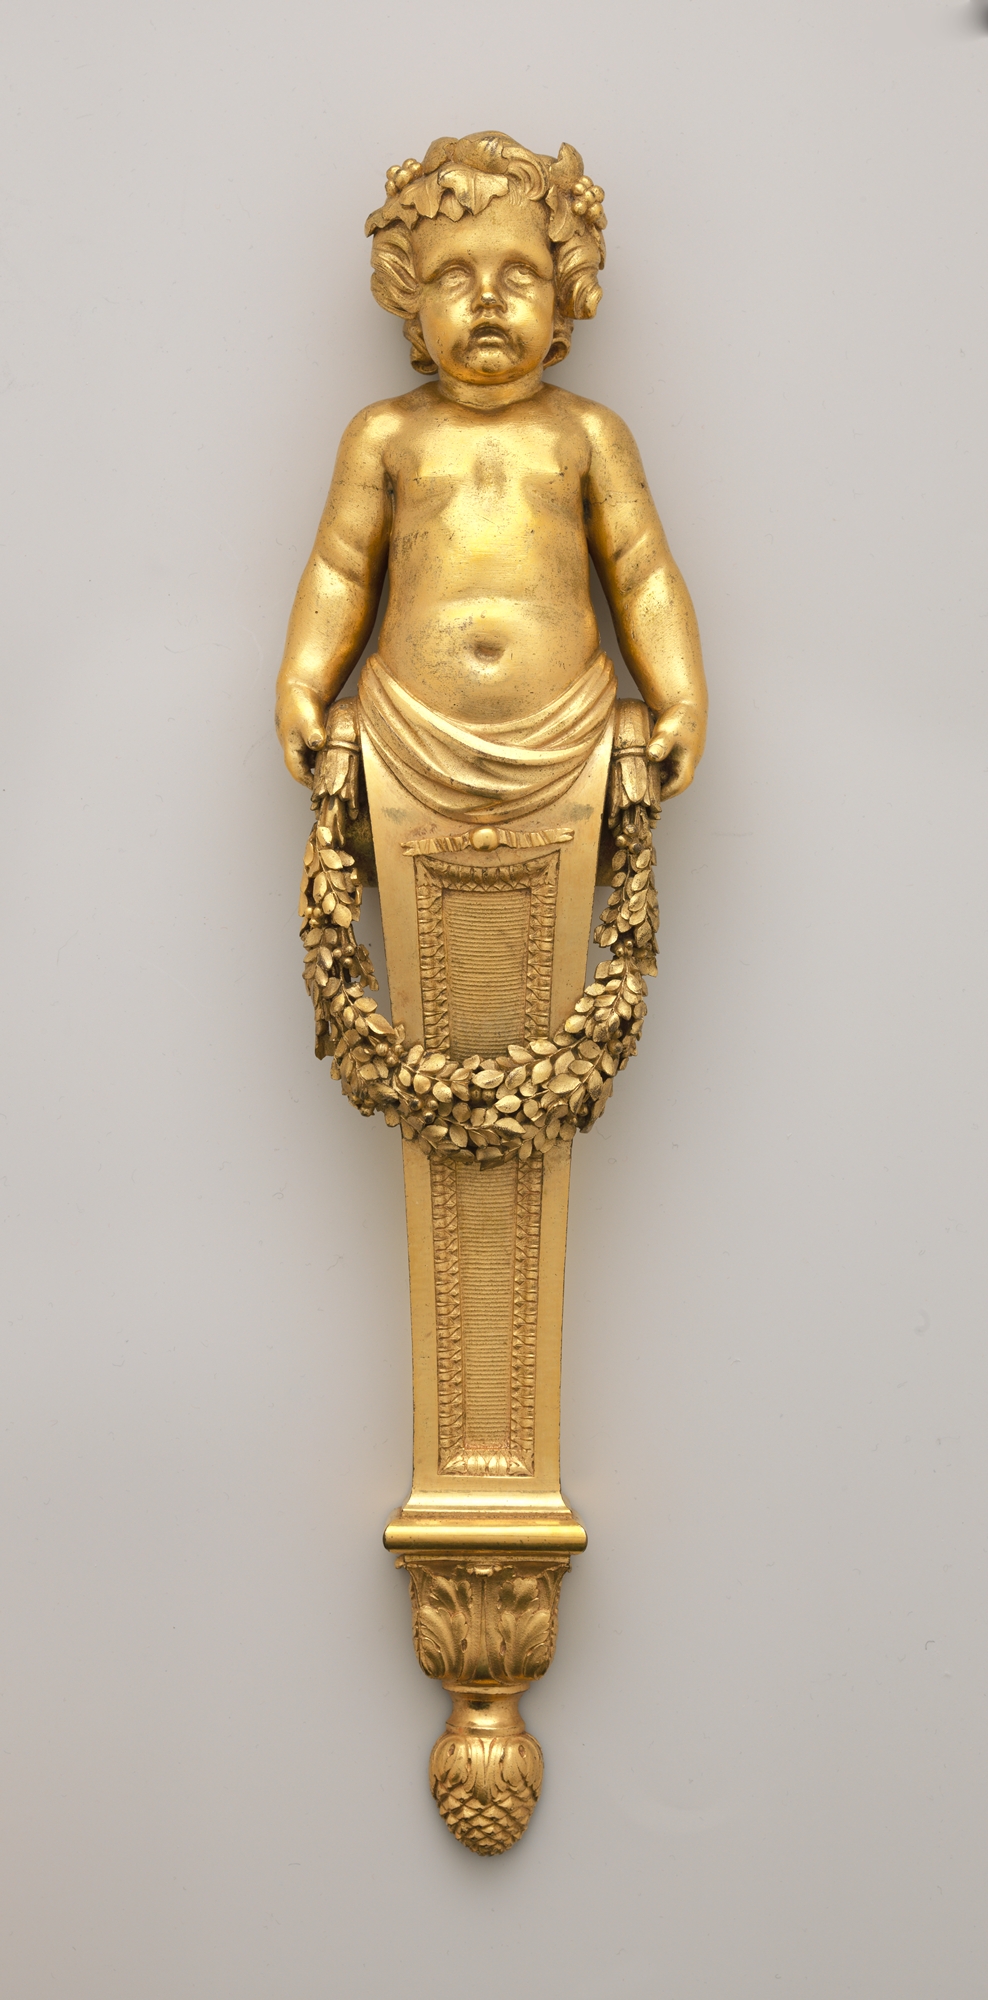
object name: chute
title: Pair of chutes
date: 1701-1800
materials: gilt bronze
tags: garlands,boys